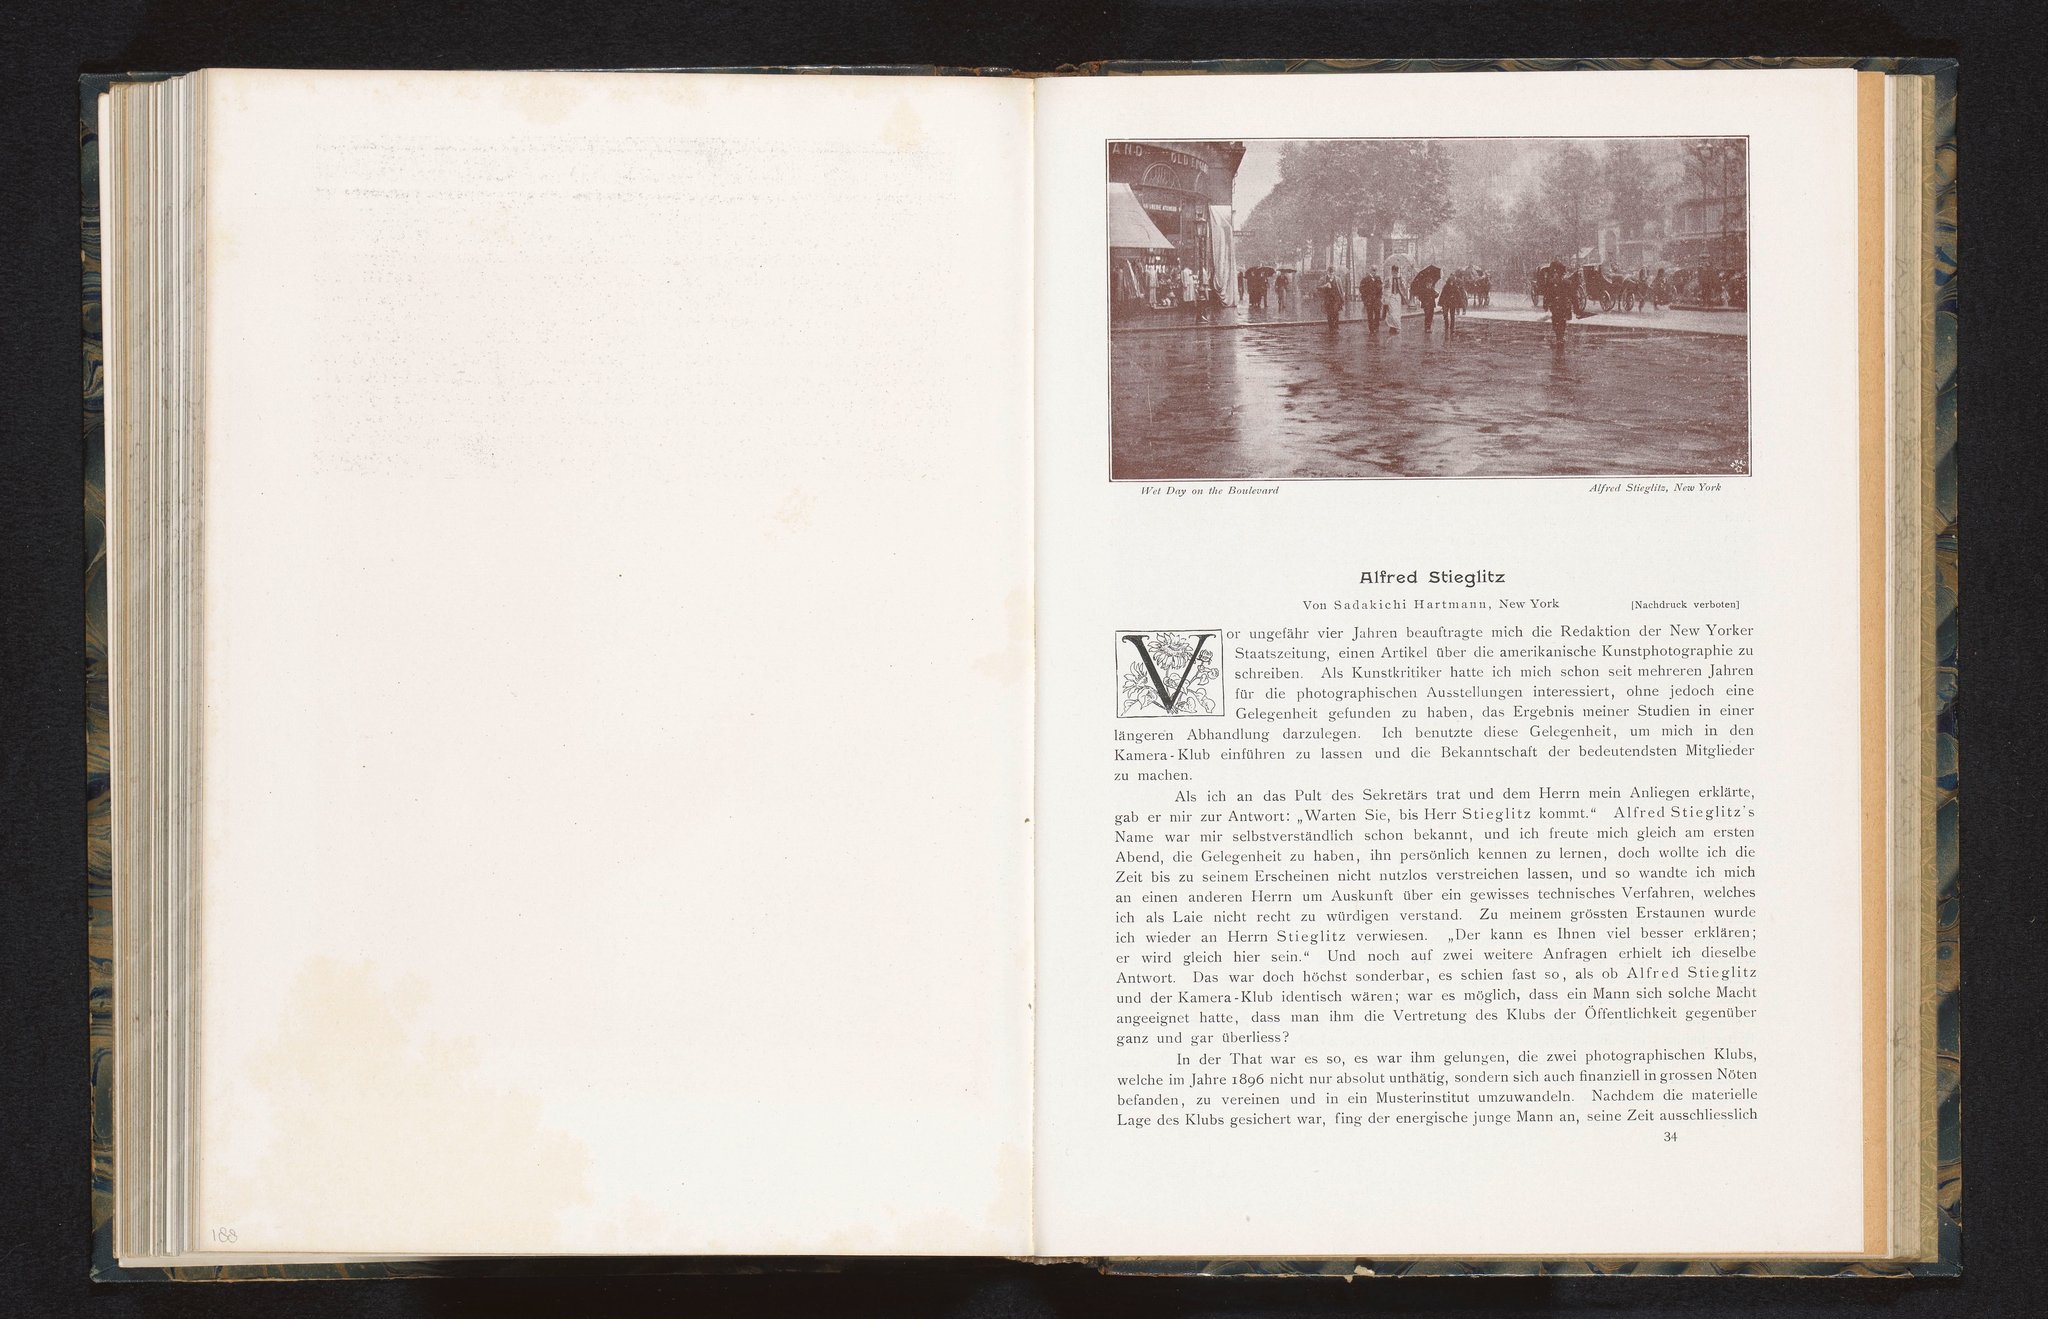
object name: photomechanical print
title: Wet day on the boulevard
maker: alfred stieglitz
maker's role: fotograaf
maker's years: 1864-1946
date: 1895-1900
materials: paper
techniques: autotype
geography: berlin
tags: umbrella, street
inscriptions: monogram: ‘MR&C’